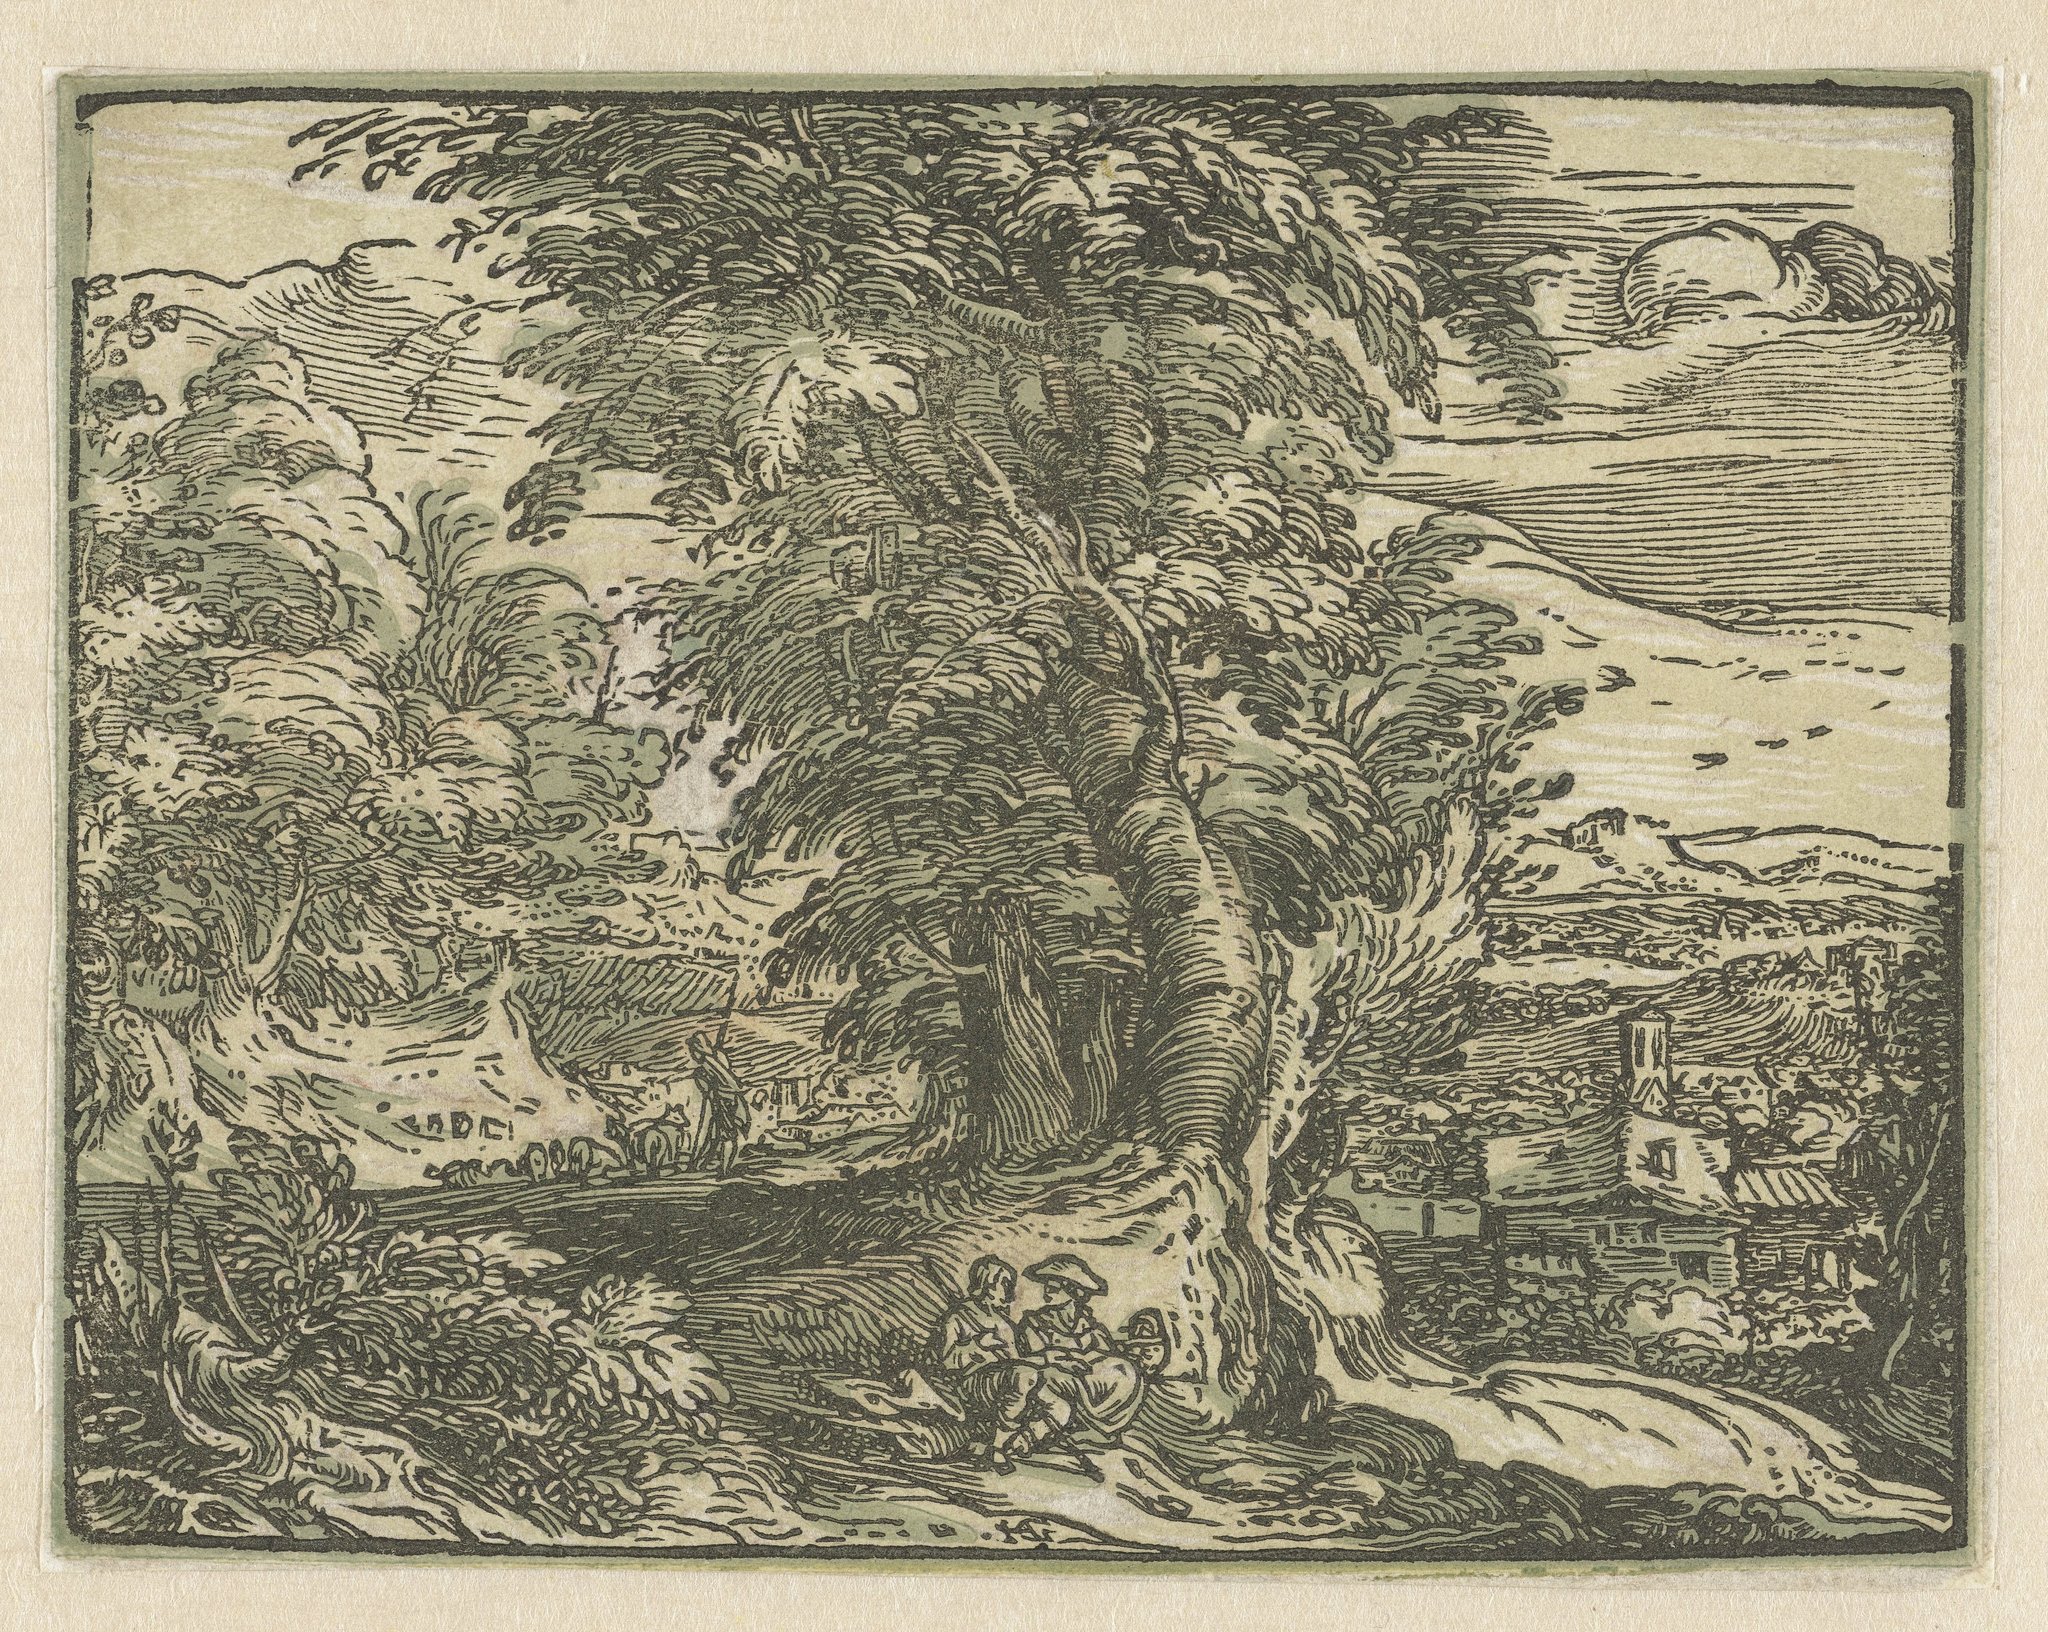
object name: print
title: Vier kleine landschappen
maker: hendrick goltzius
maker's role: draughtsman, painter, print maker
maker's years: 1558-1617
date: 1597-1600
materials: paper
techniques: woodcut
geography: haarlem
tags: landscapes in the temperate zone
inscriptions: collector's mark: Lugt 2502 (?), inscription: ‘G. Storck a Milano 1799. / In. No. 10277.’, collector's mark: Lugt 2228, collector's mark: Lugt 2760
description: Boslandschap; op de voorgrond een man en een vrouw zittend onder een boom. Deze prent is onderdeel van een serie van vier kleine houtsnedes met landschappen.